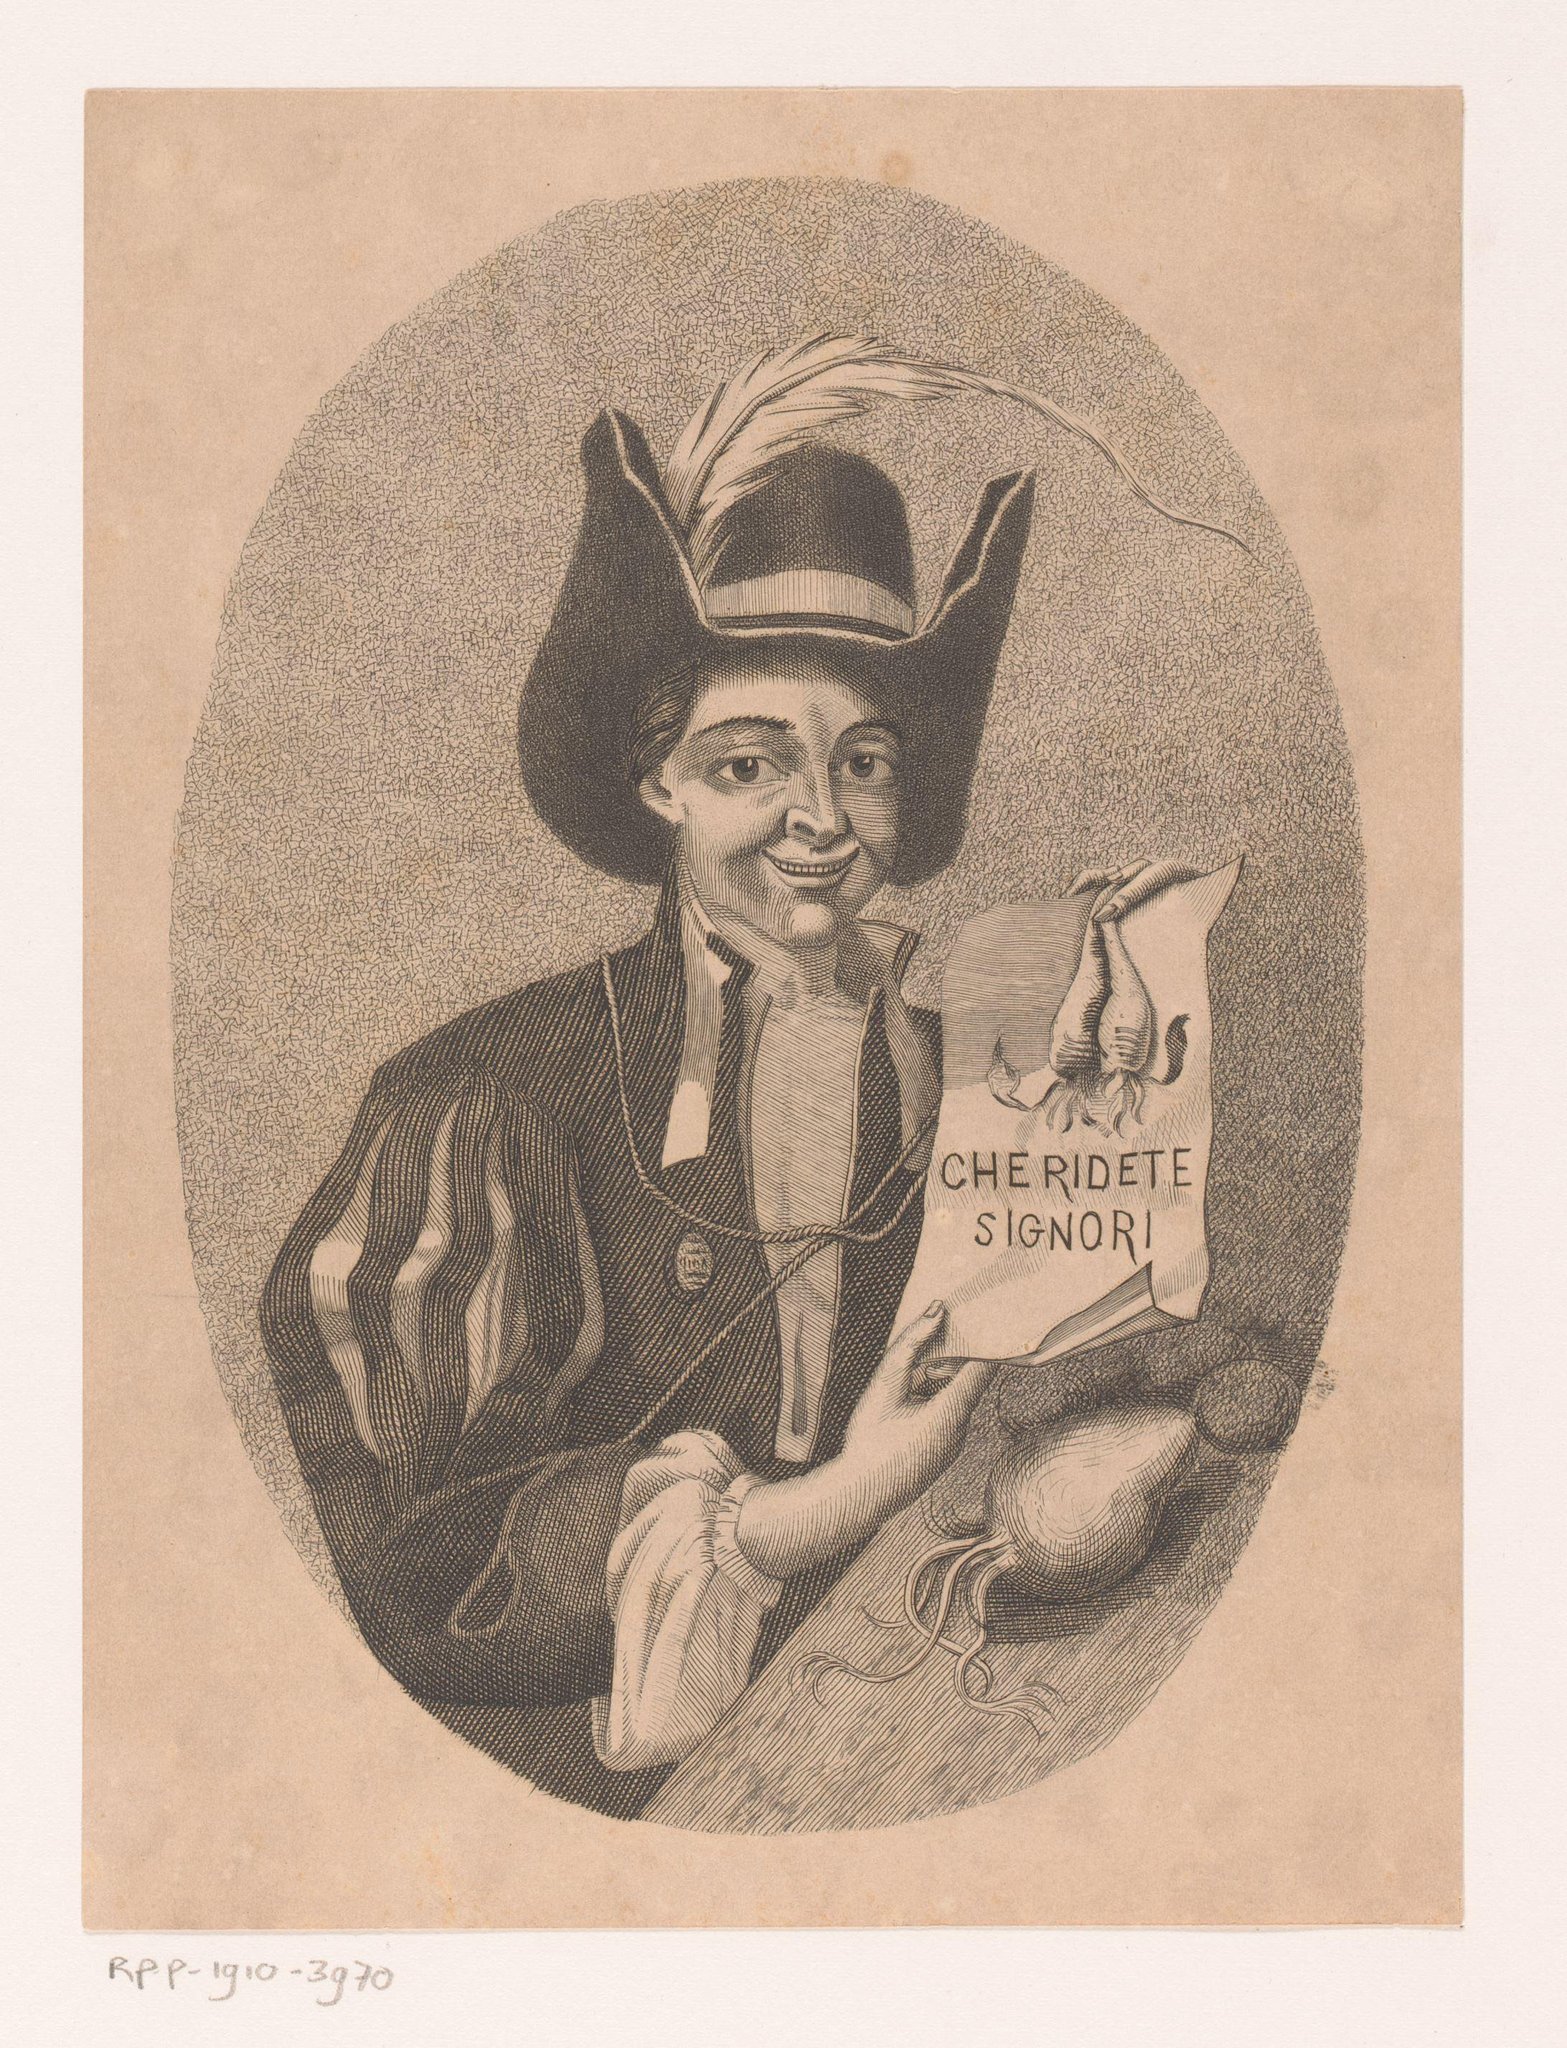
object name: print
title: Lachende jongeman met hoed en een blad in zijn handen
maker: louis jaugey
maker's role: print maker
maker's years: 1837-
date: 1862-1878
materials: paper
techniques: engraving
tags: head-gear, youth, adolescent, plants ~ agriculture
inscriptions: collector's mark: Lugt 2228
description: Op het blad dat de man vasthoudt en op tafel zijn knollen afgebeeld.